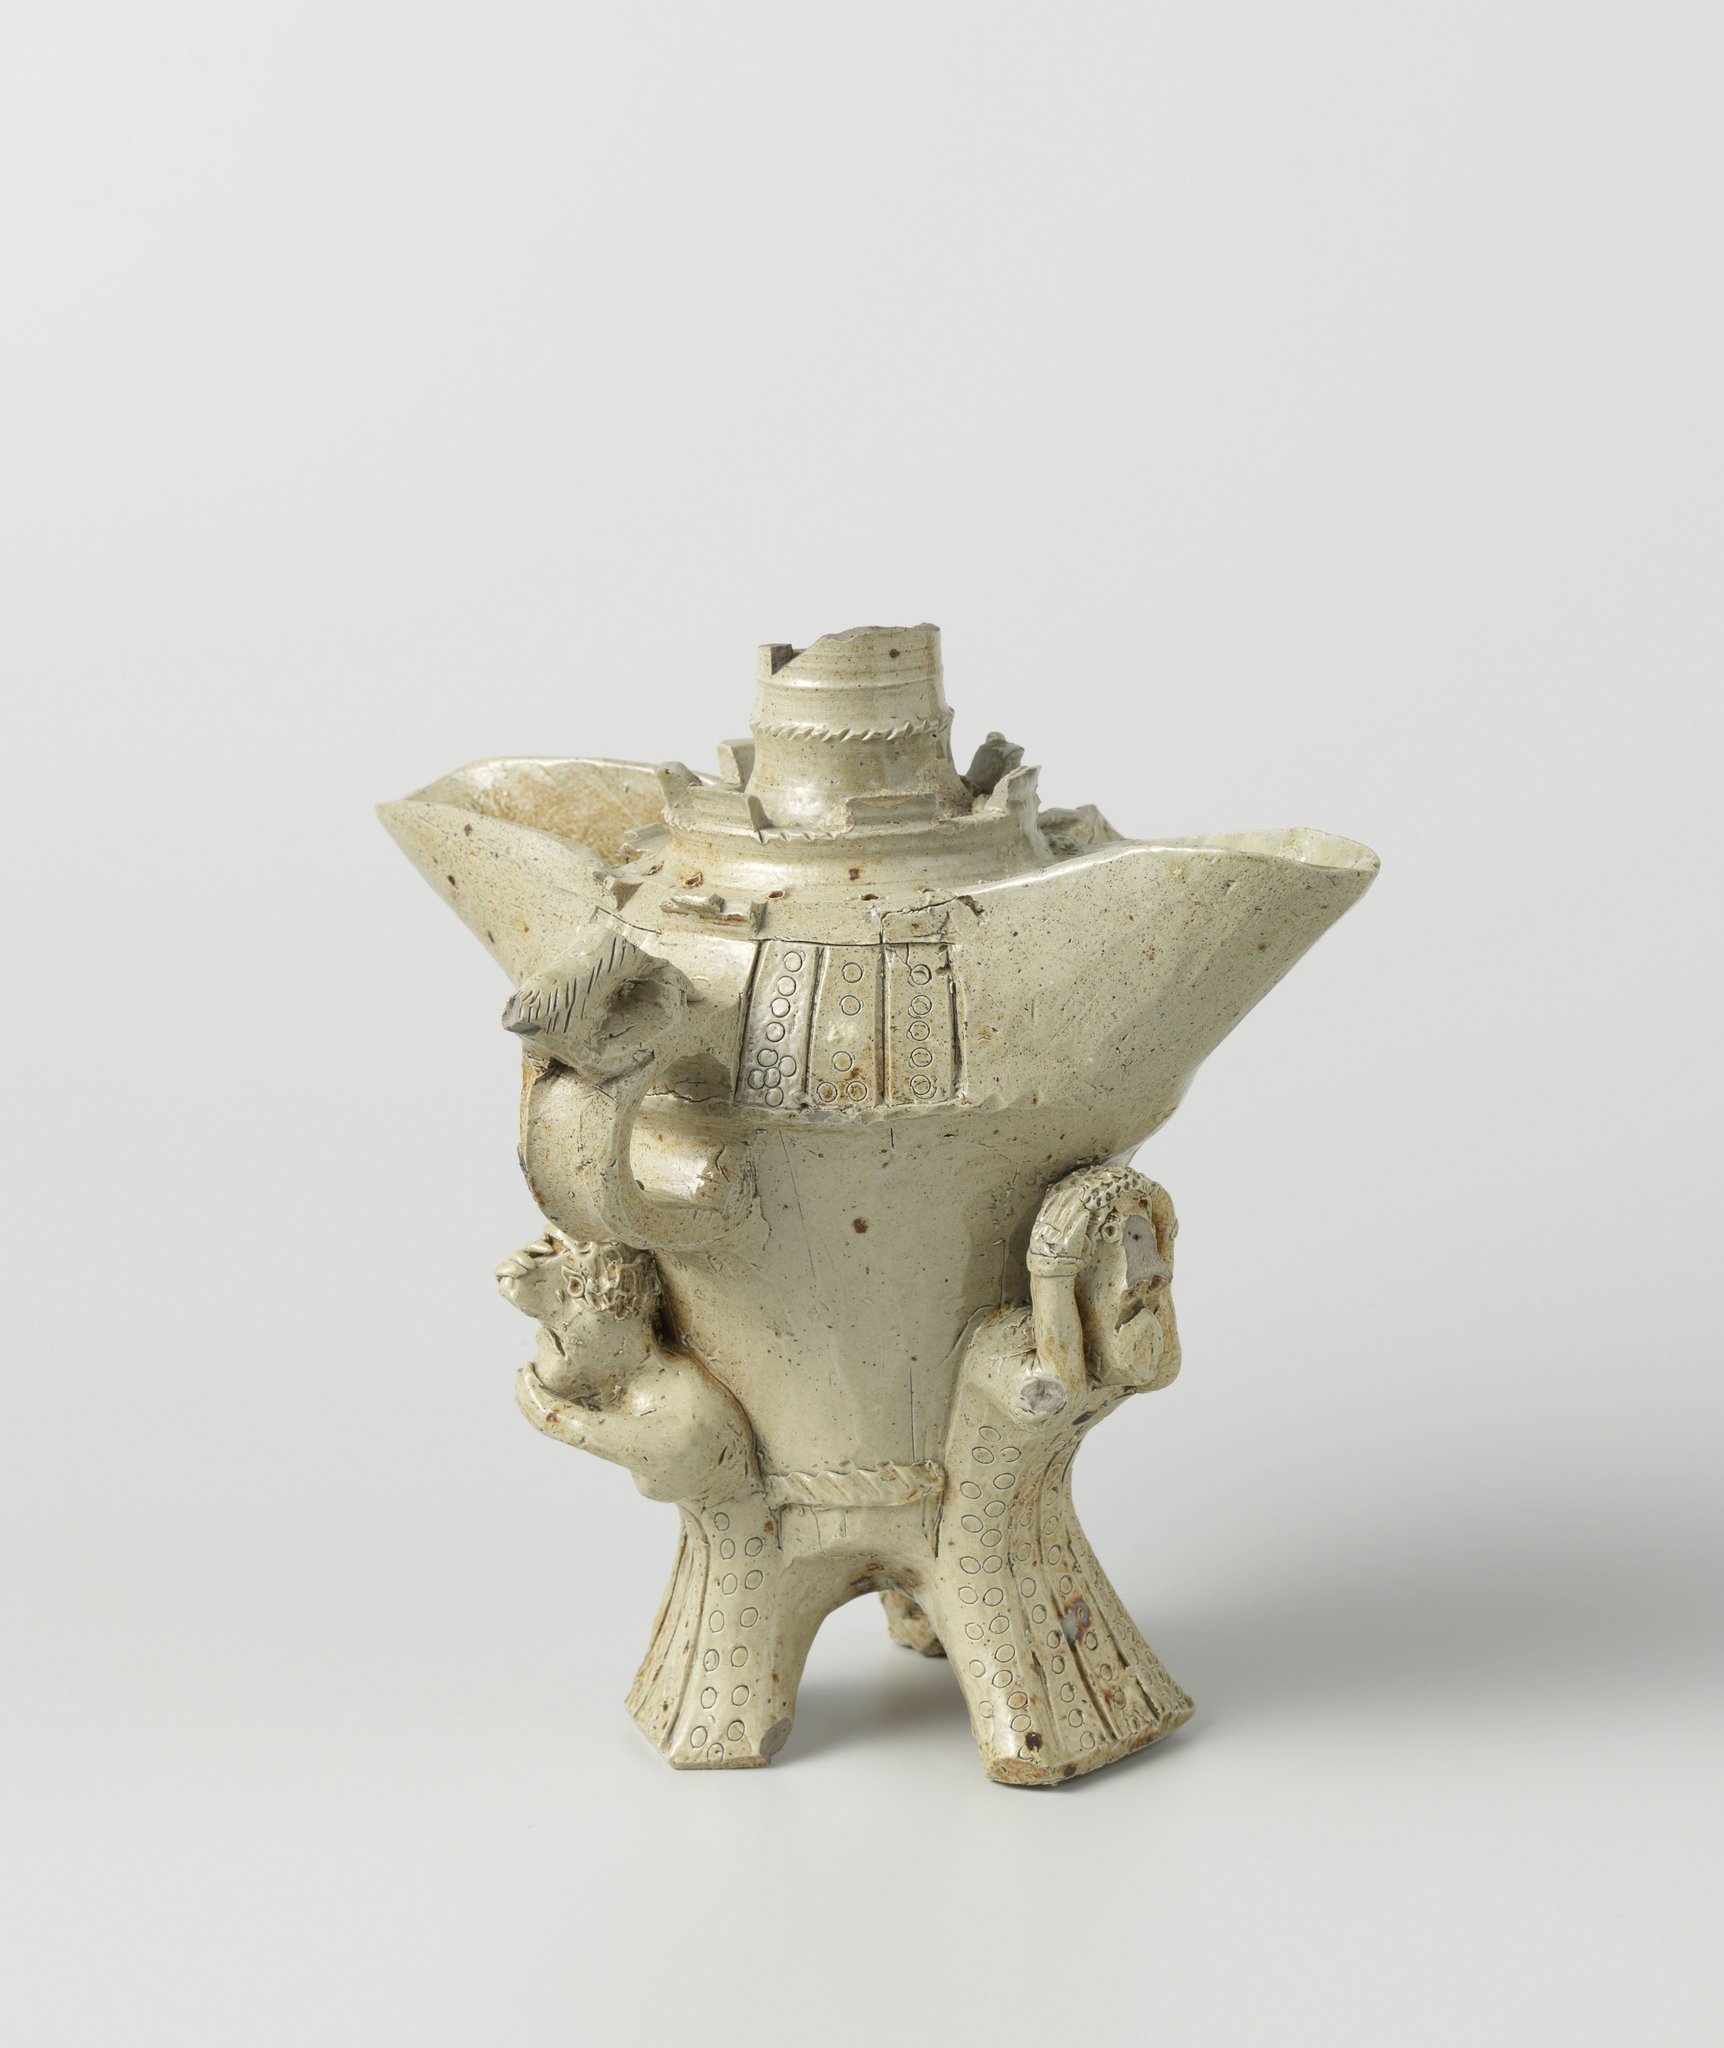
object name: drinkvat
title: Vessel with two spouts and carried by three figures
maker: Anonymous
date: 1600-1620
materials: glaze, stoneware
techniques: printing, firing, forming, relief, turning, vitrification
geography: raeren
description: Drink- of schenkvat van steengoed gedragen door drie mansfiguren en met een smalle nek en twee brede tuiten met zeef. De twee C-vormige oren zijn bevestigd aan de schouder en het lichaam; op de oren een dierfiguur. De kan is versierd met verticale banden met gestempelde cirkels. Op de schouder een band met gemodelleerde kantelen. Raeren.